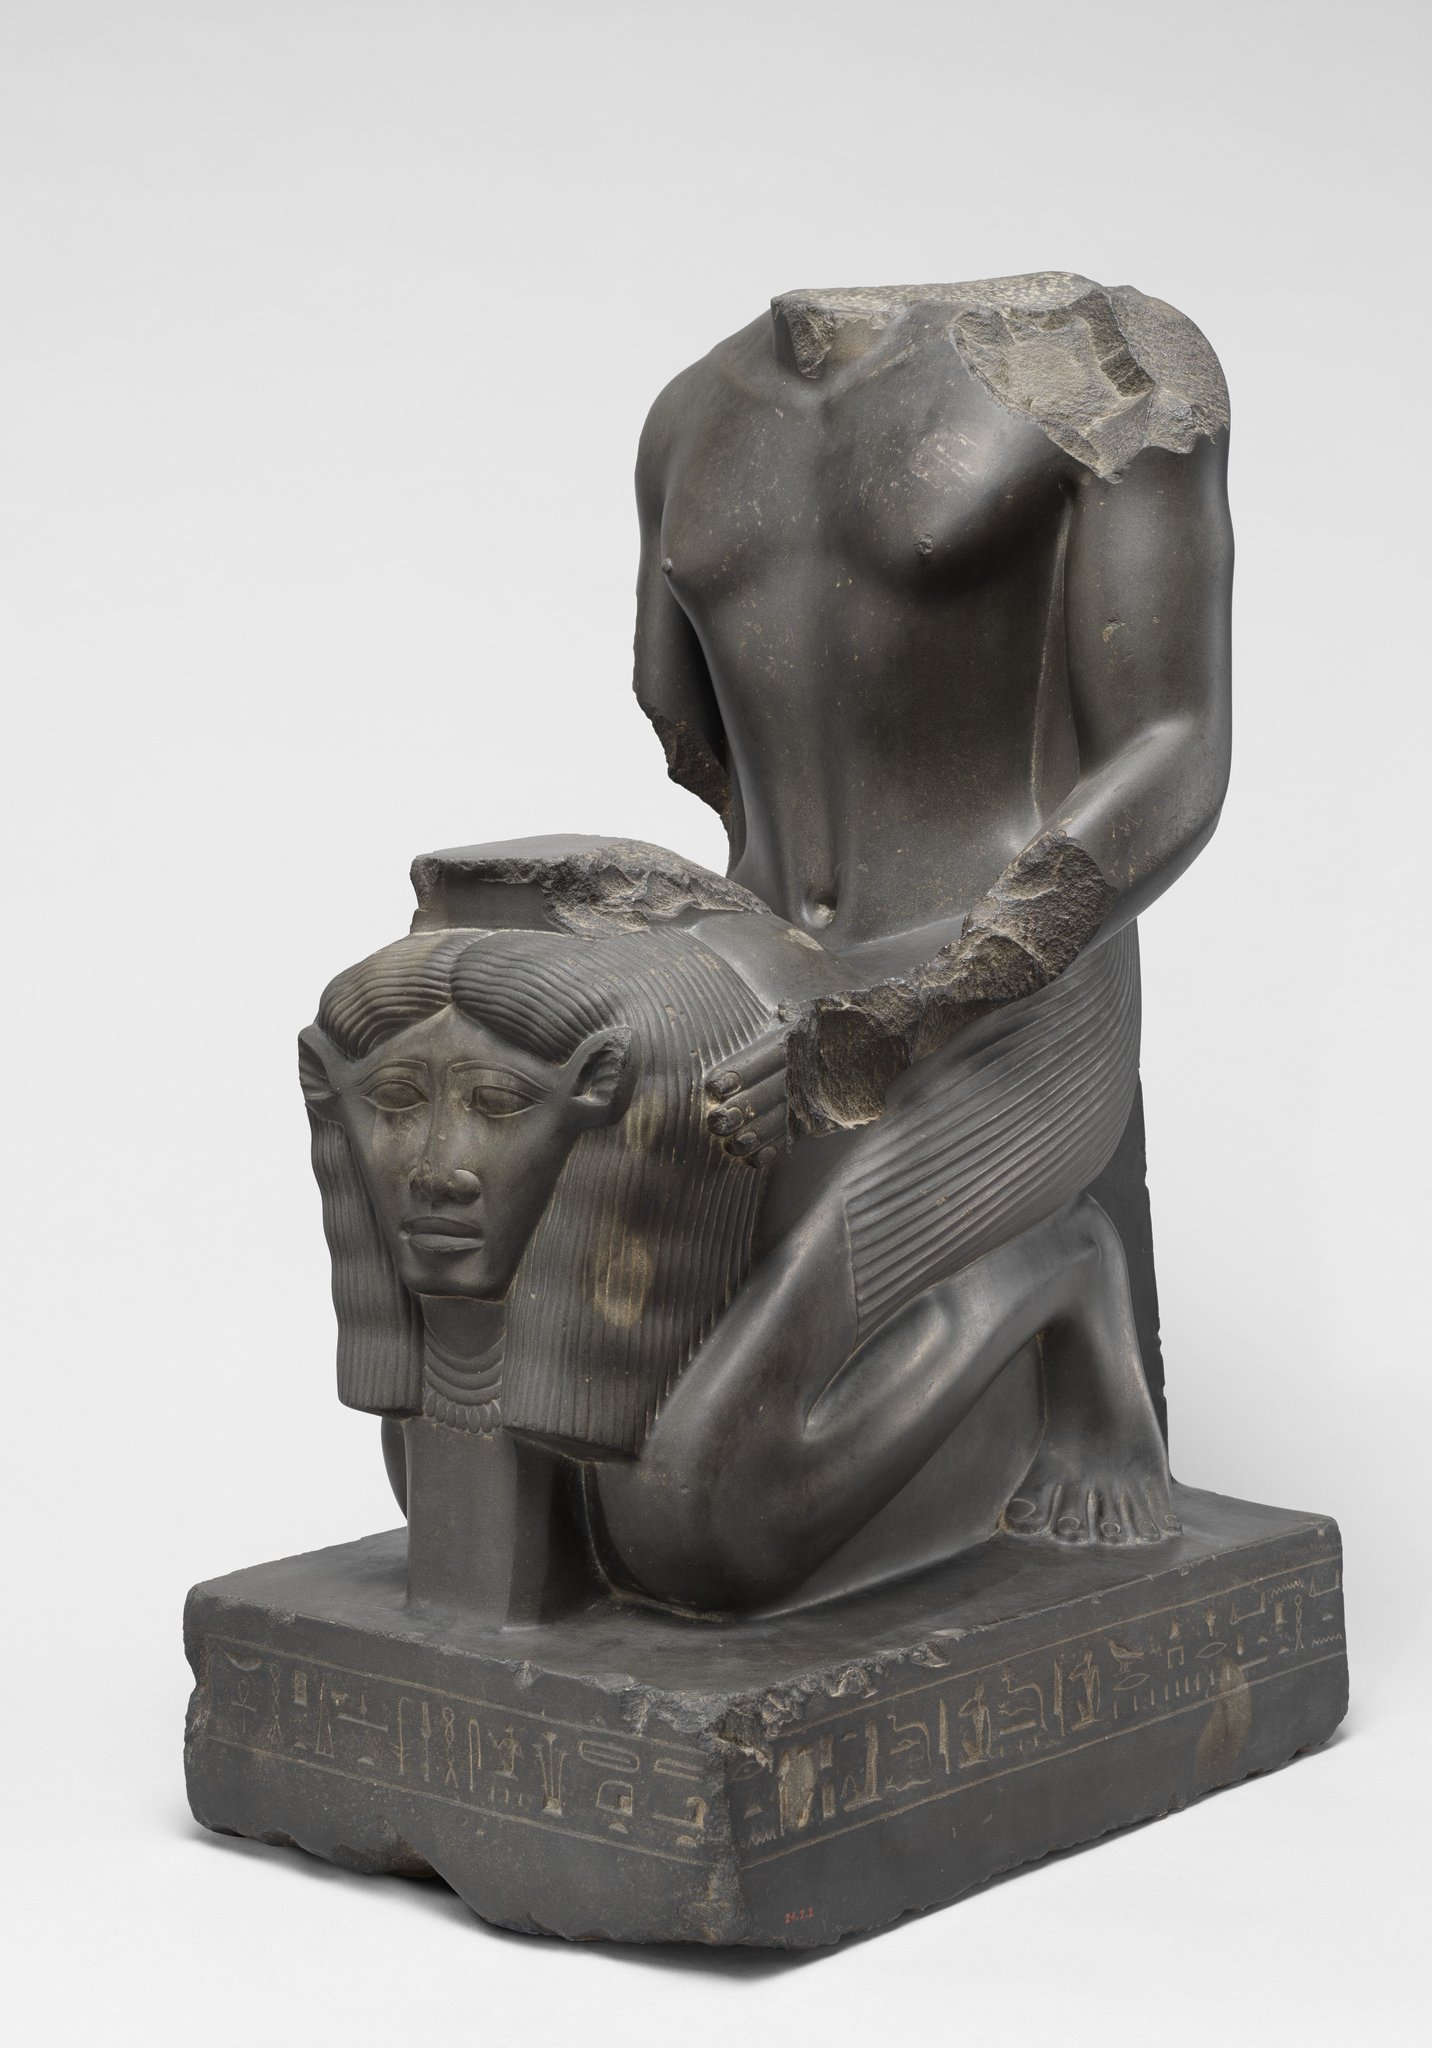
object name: statue, kneeling man, amenemopetemhat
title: Kneeling statue of Amenemopetemhat holding the Hathor emblem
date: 664-610 BCE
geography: memphite region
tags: men